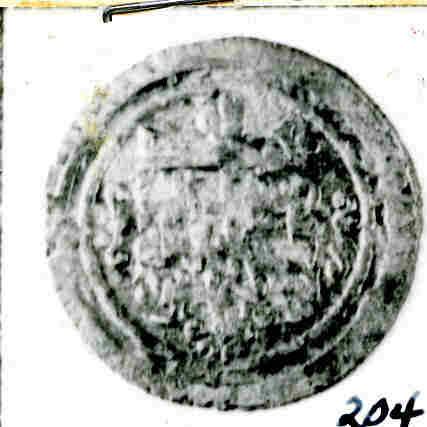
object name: coin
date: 951-1022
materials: copper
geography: iran